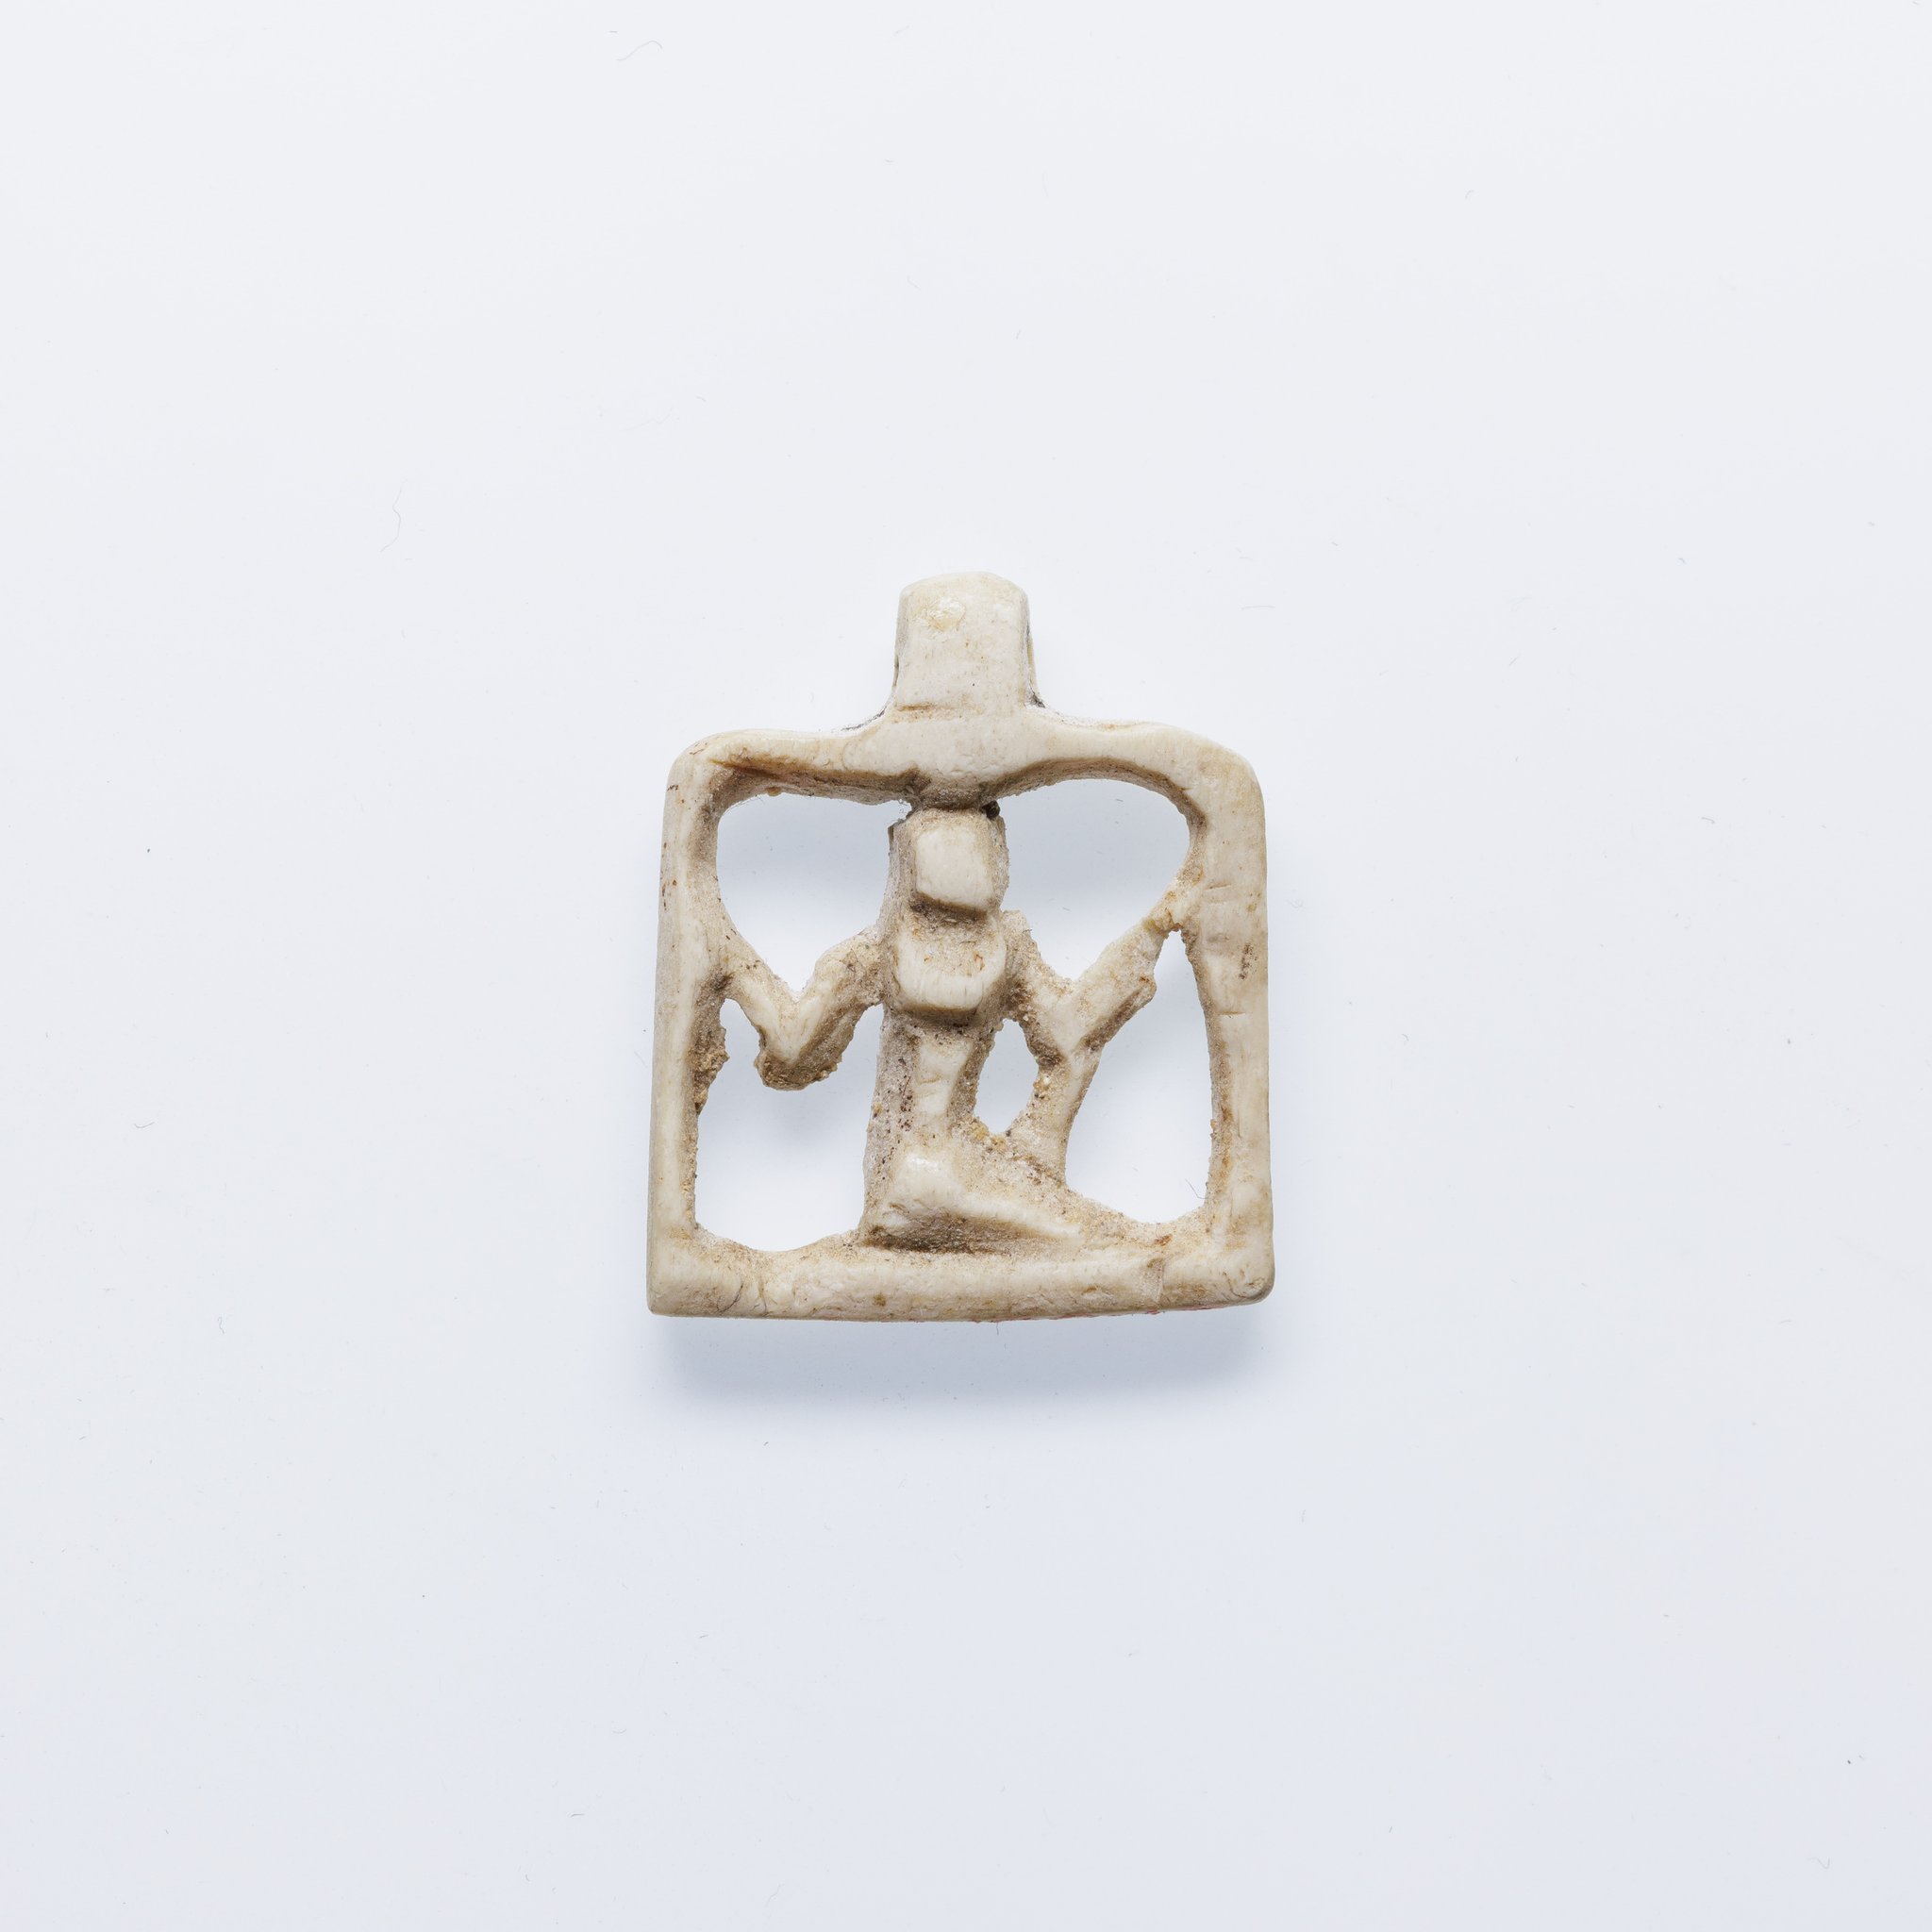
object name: amulet, heh sign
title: Heh sign amulet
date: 2150-1950 BCE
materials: bone, ivory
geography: egypt